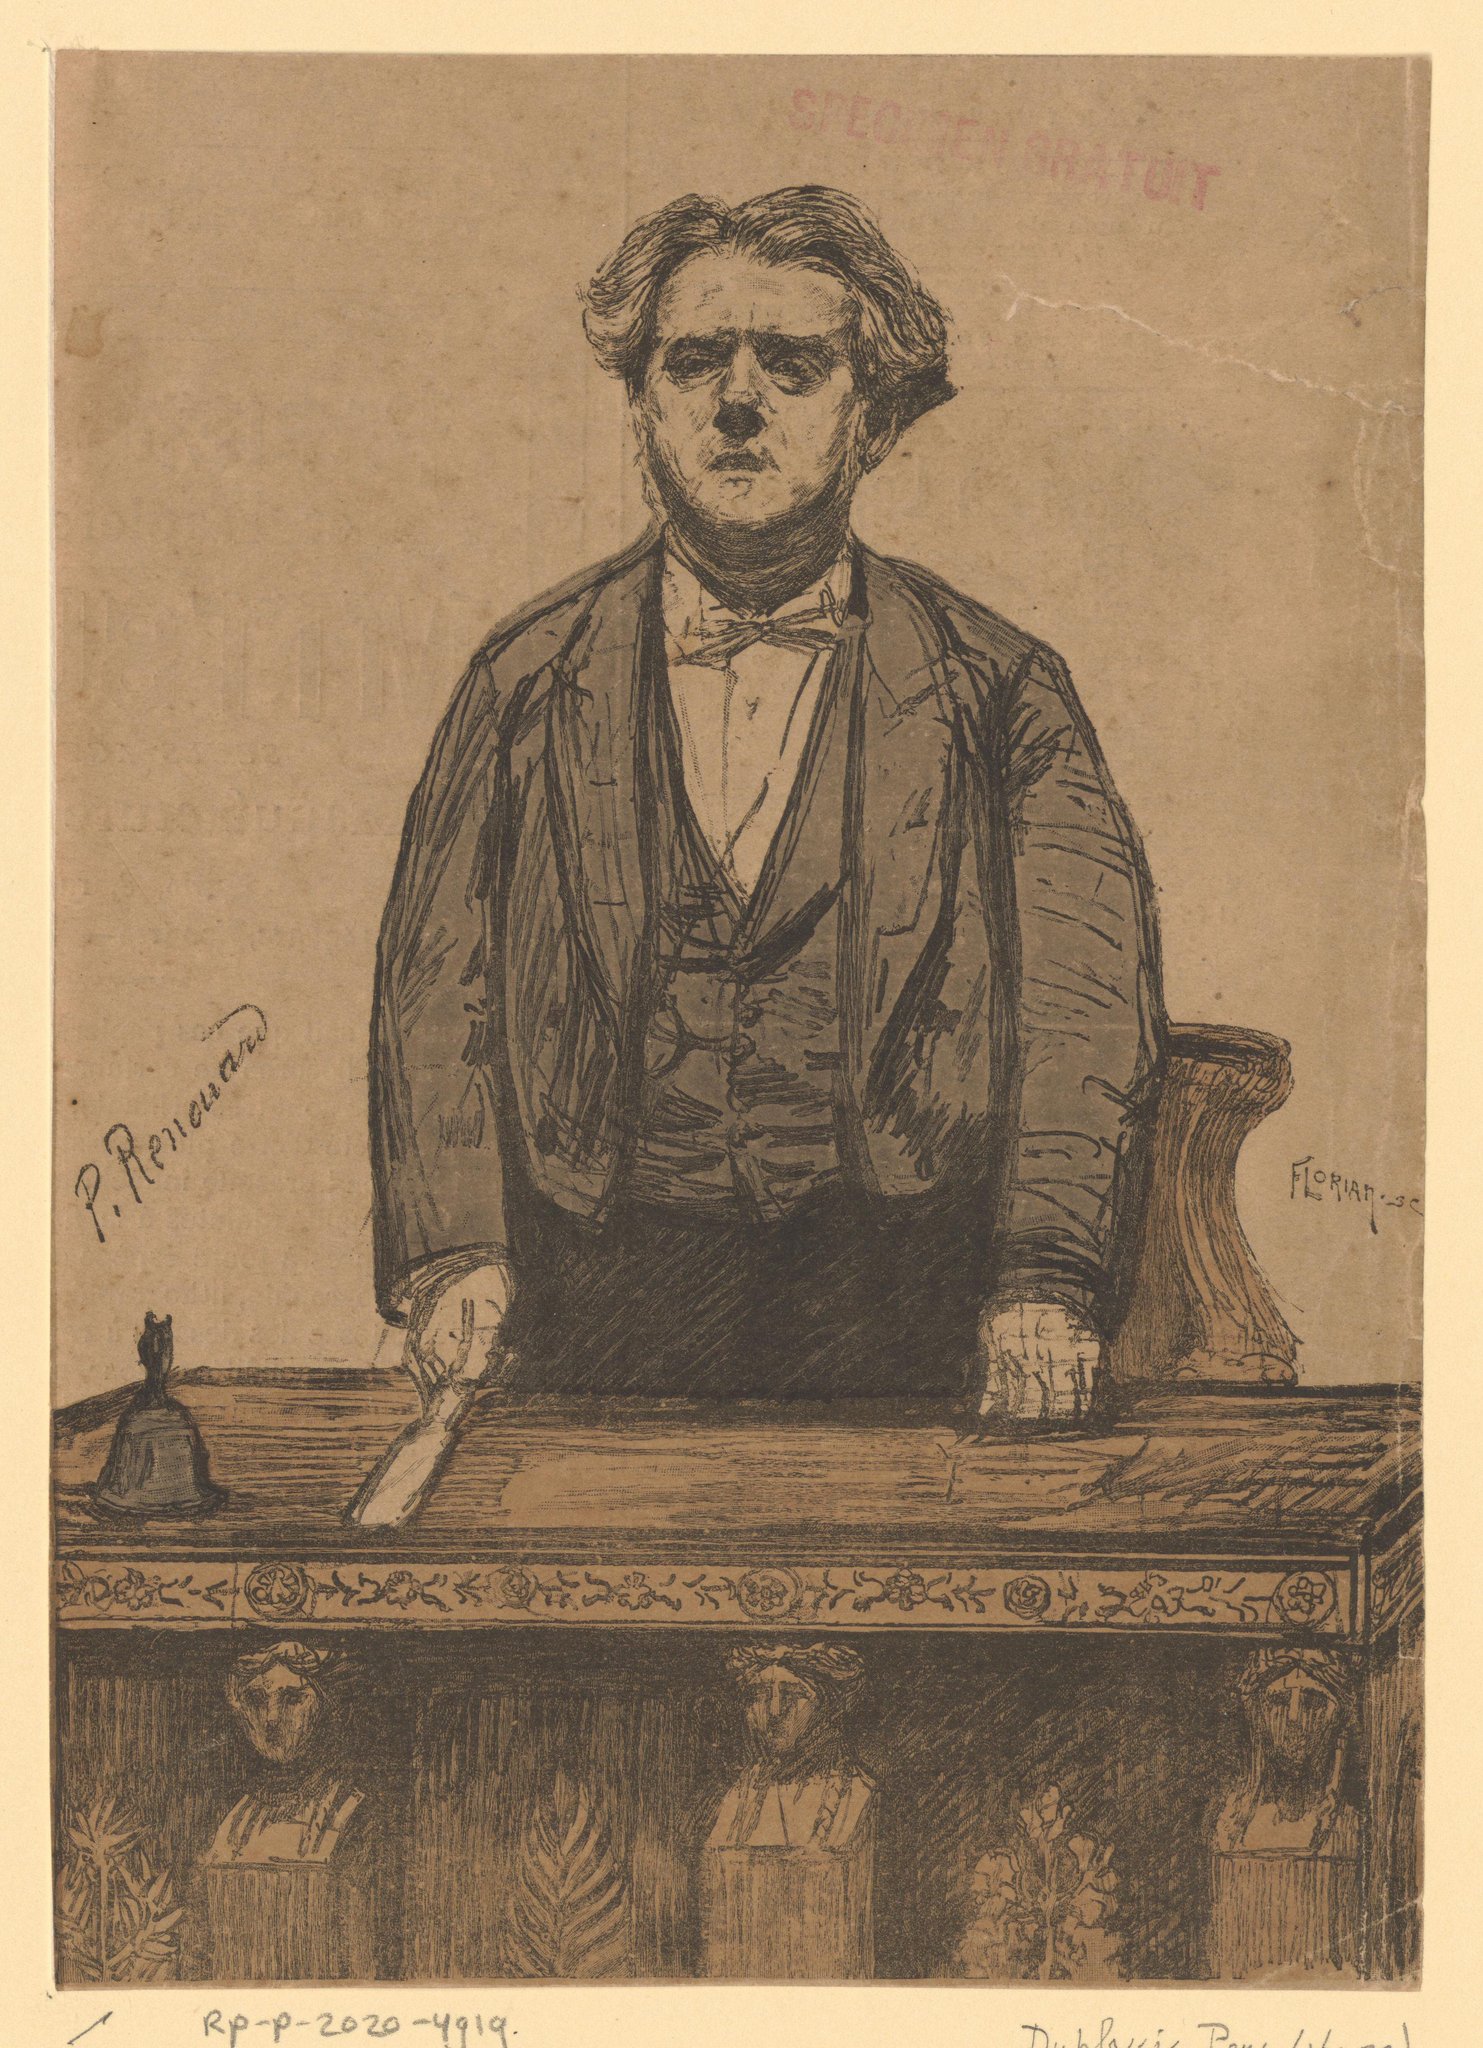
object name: print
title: Portret van Charles Floquet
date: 1806-1886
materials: paper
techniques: hand coloring, letterpress printing, engraving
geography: paris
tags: historical persons, lawyer, attorney at law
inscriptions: stamp: ‘Specimen gratuit’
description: Prent uit: Revue illustrée (1886), 15 juni 1886.